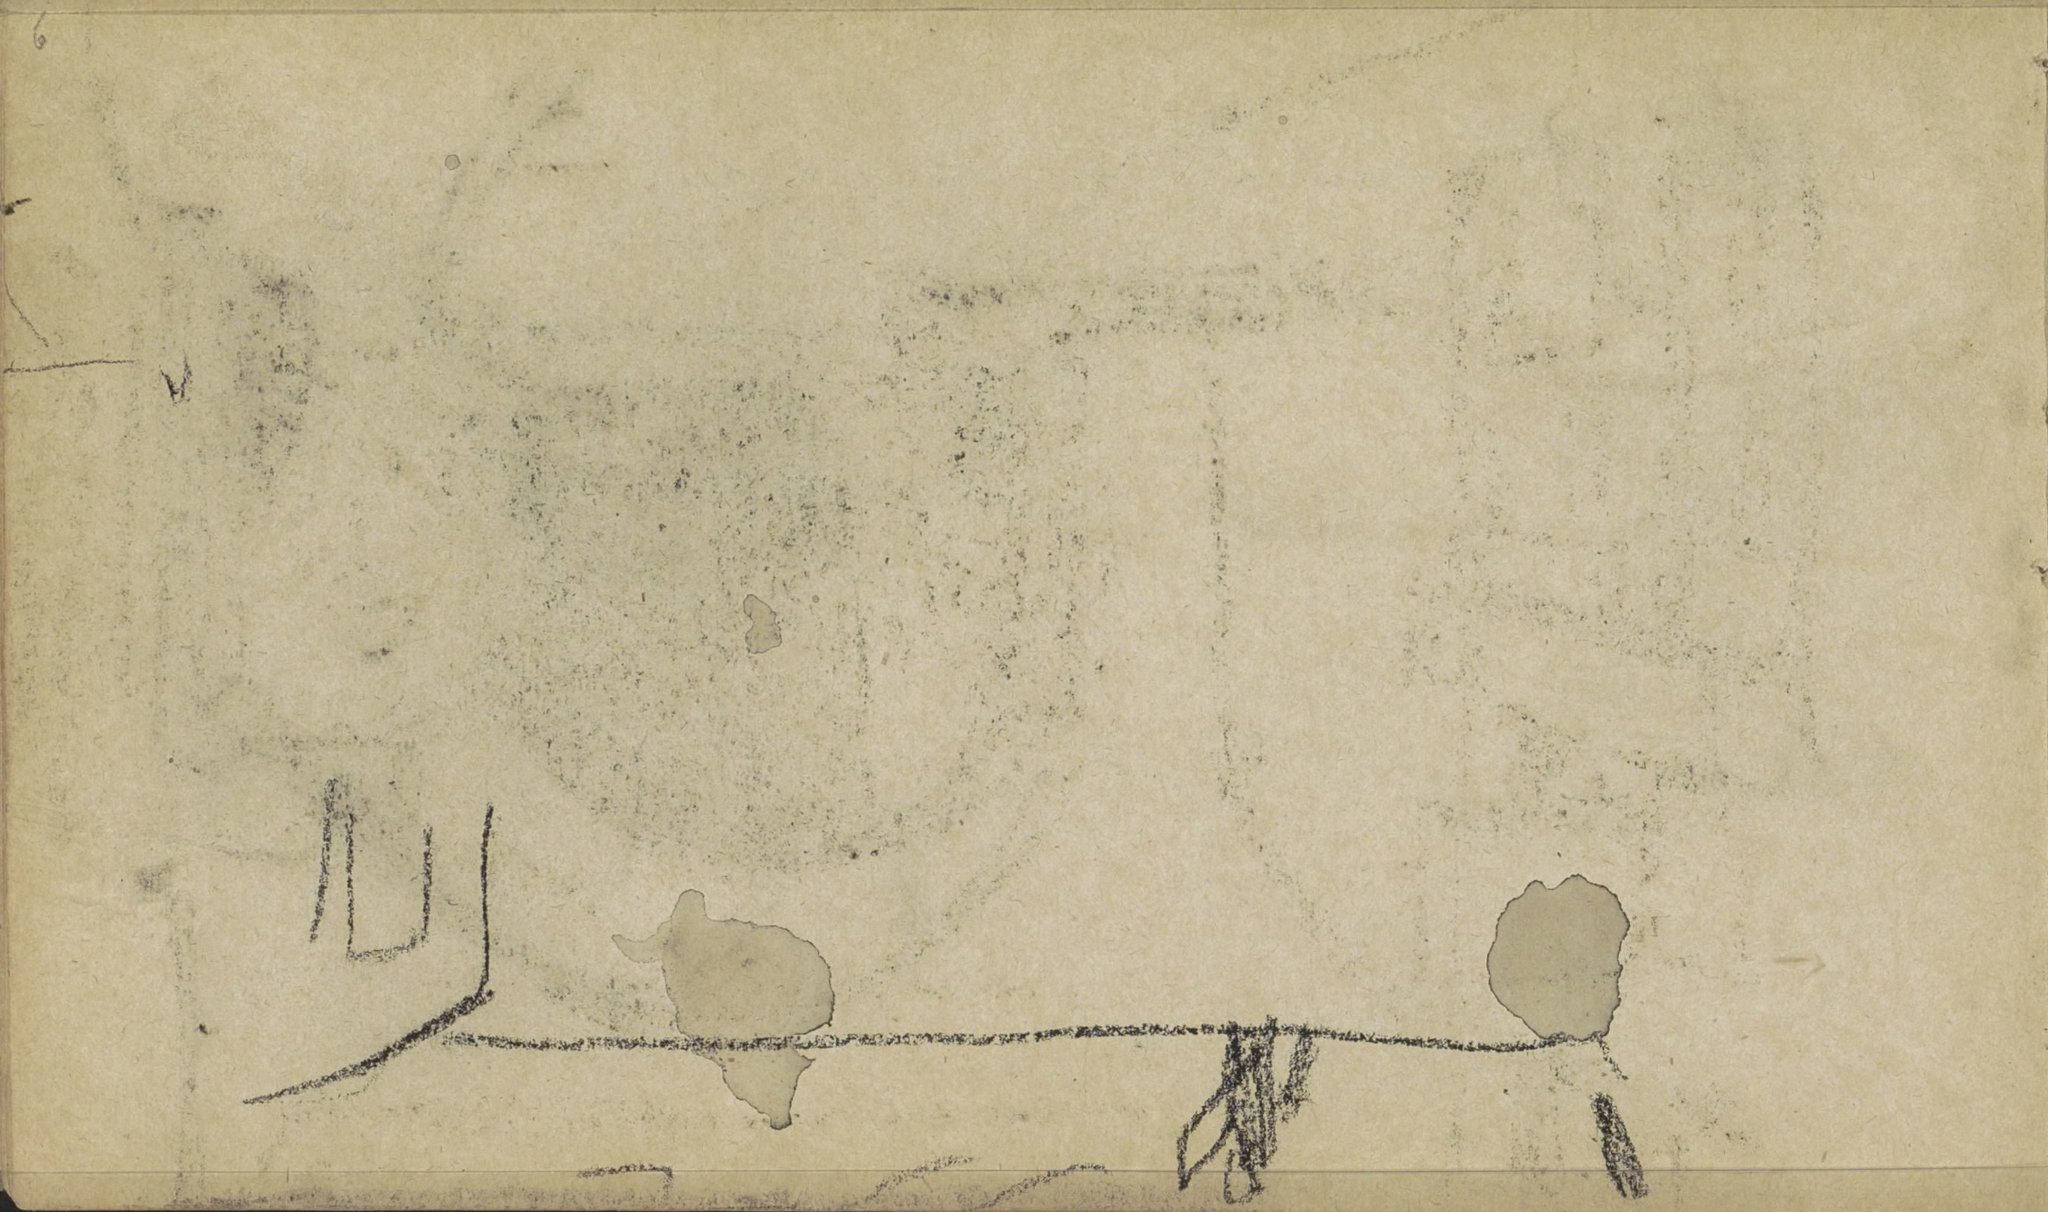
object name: sketchbook leaf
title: Architectuurstudie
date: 1888-1897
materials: chalk, paper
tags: architecture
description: Pagina 6 uit een schetsboek met 25 bladen.